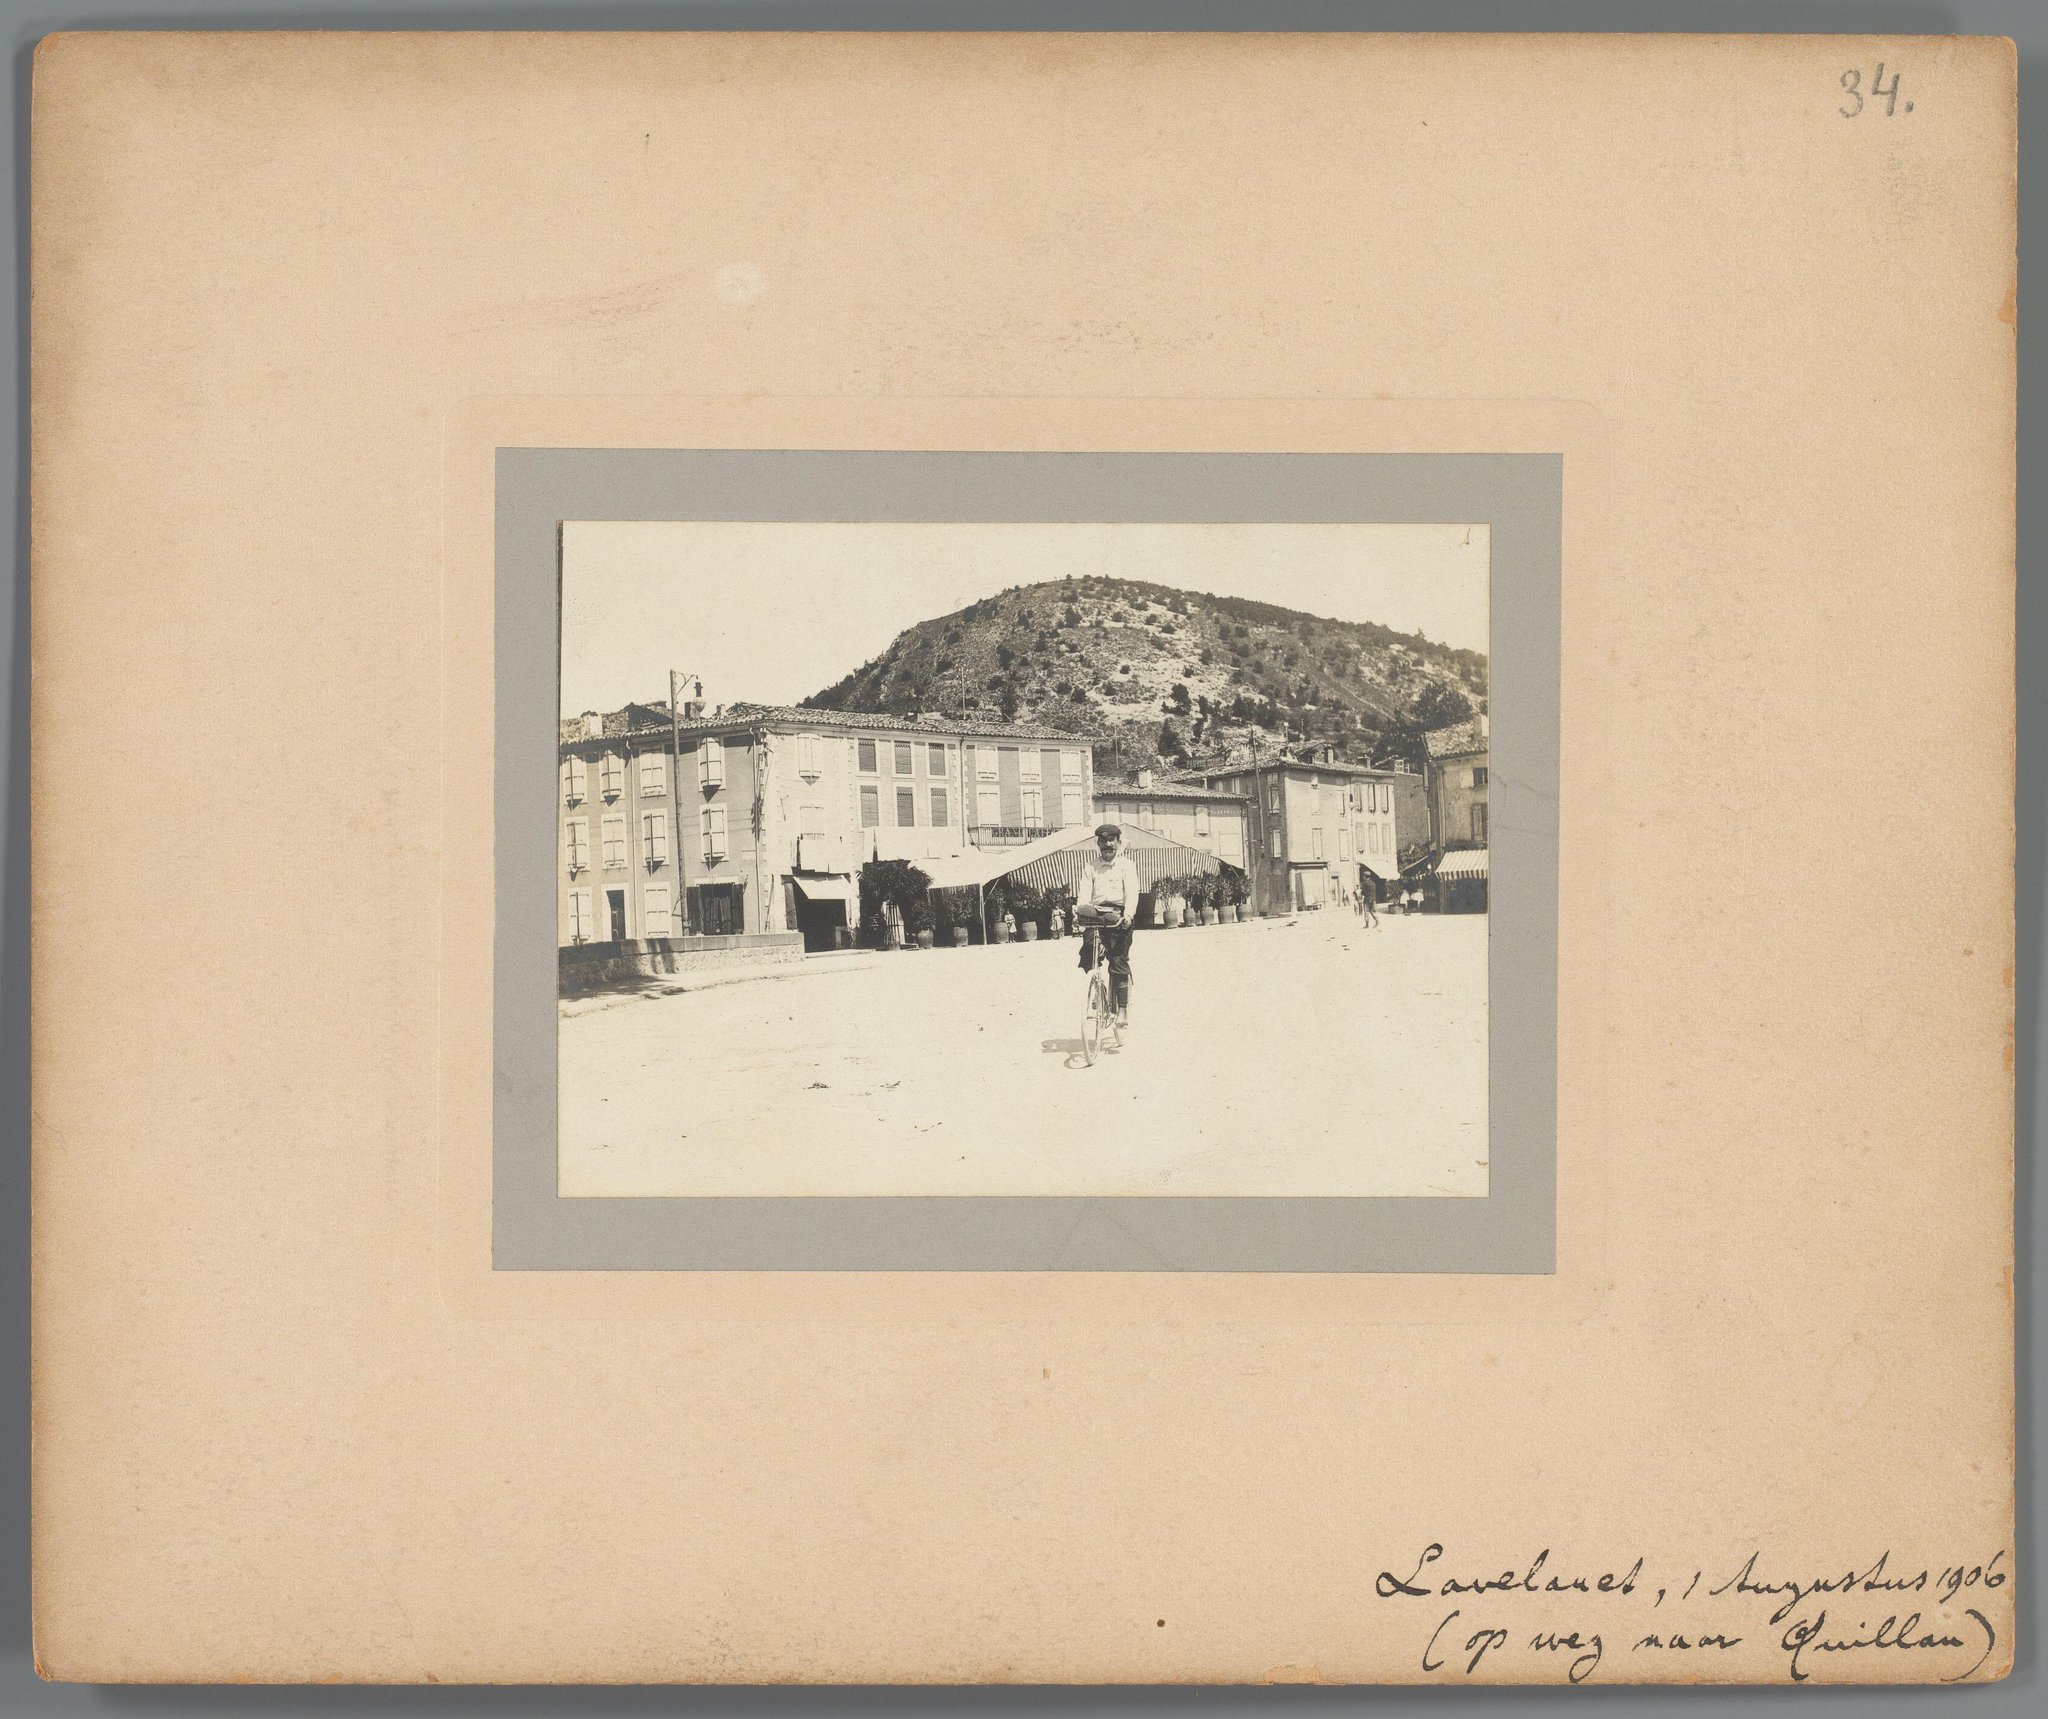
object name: photograph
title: Lavelanet (op weg naar Quillan)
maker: françois buys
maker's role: advocaat, amateurfotograaf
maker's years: 1871-1934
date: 1906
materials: paper, cardboard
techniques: gelatin silver print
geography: lavelanet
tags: square, place, circus, etc., bicycle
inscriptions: number: ‘34’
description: Deze foto maakt deel uit van een groep van 49 foto's.